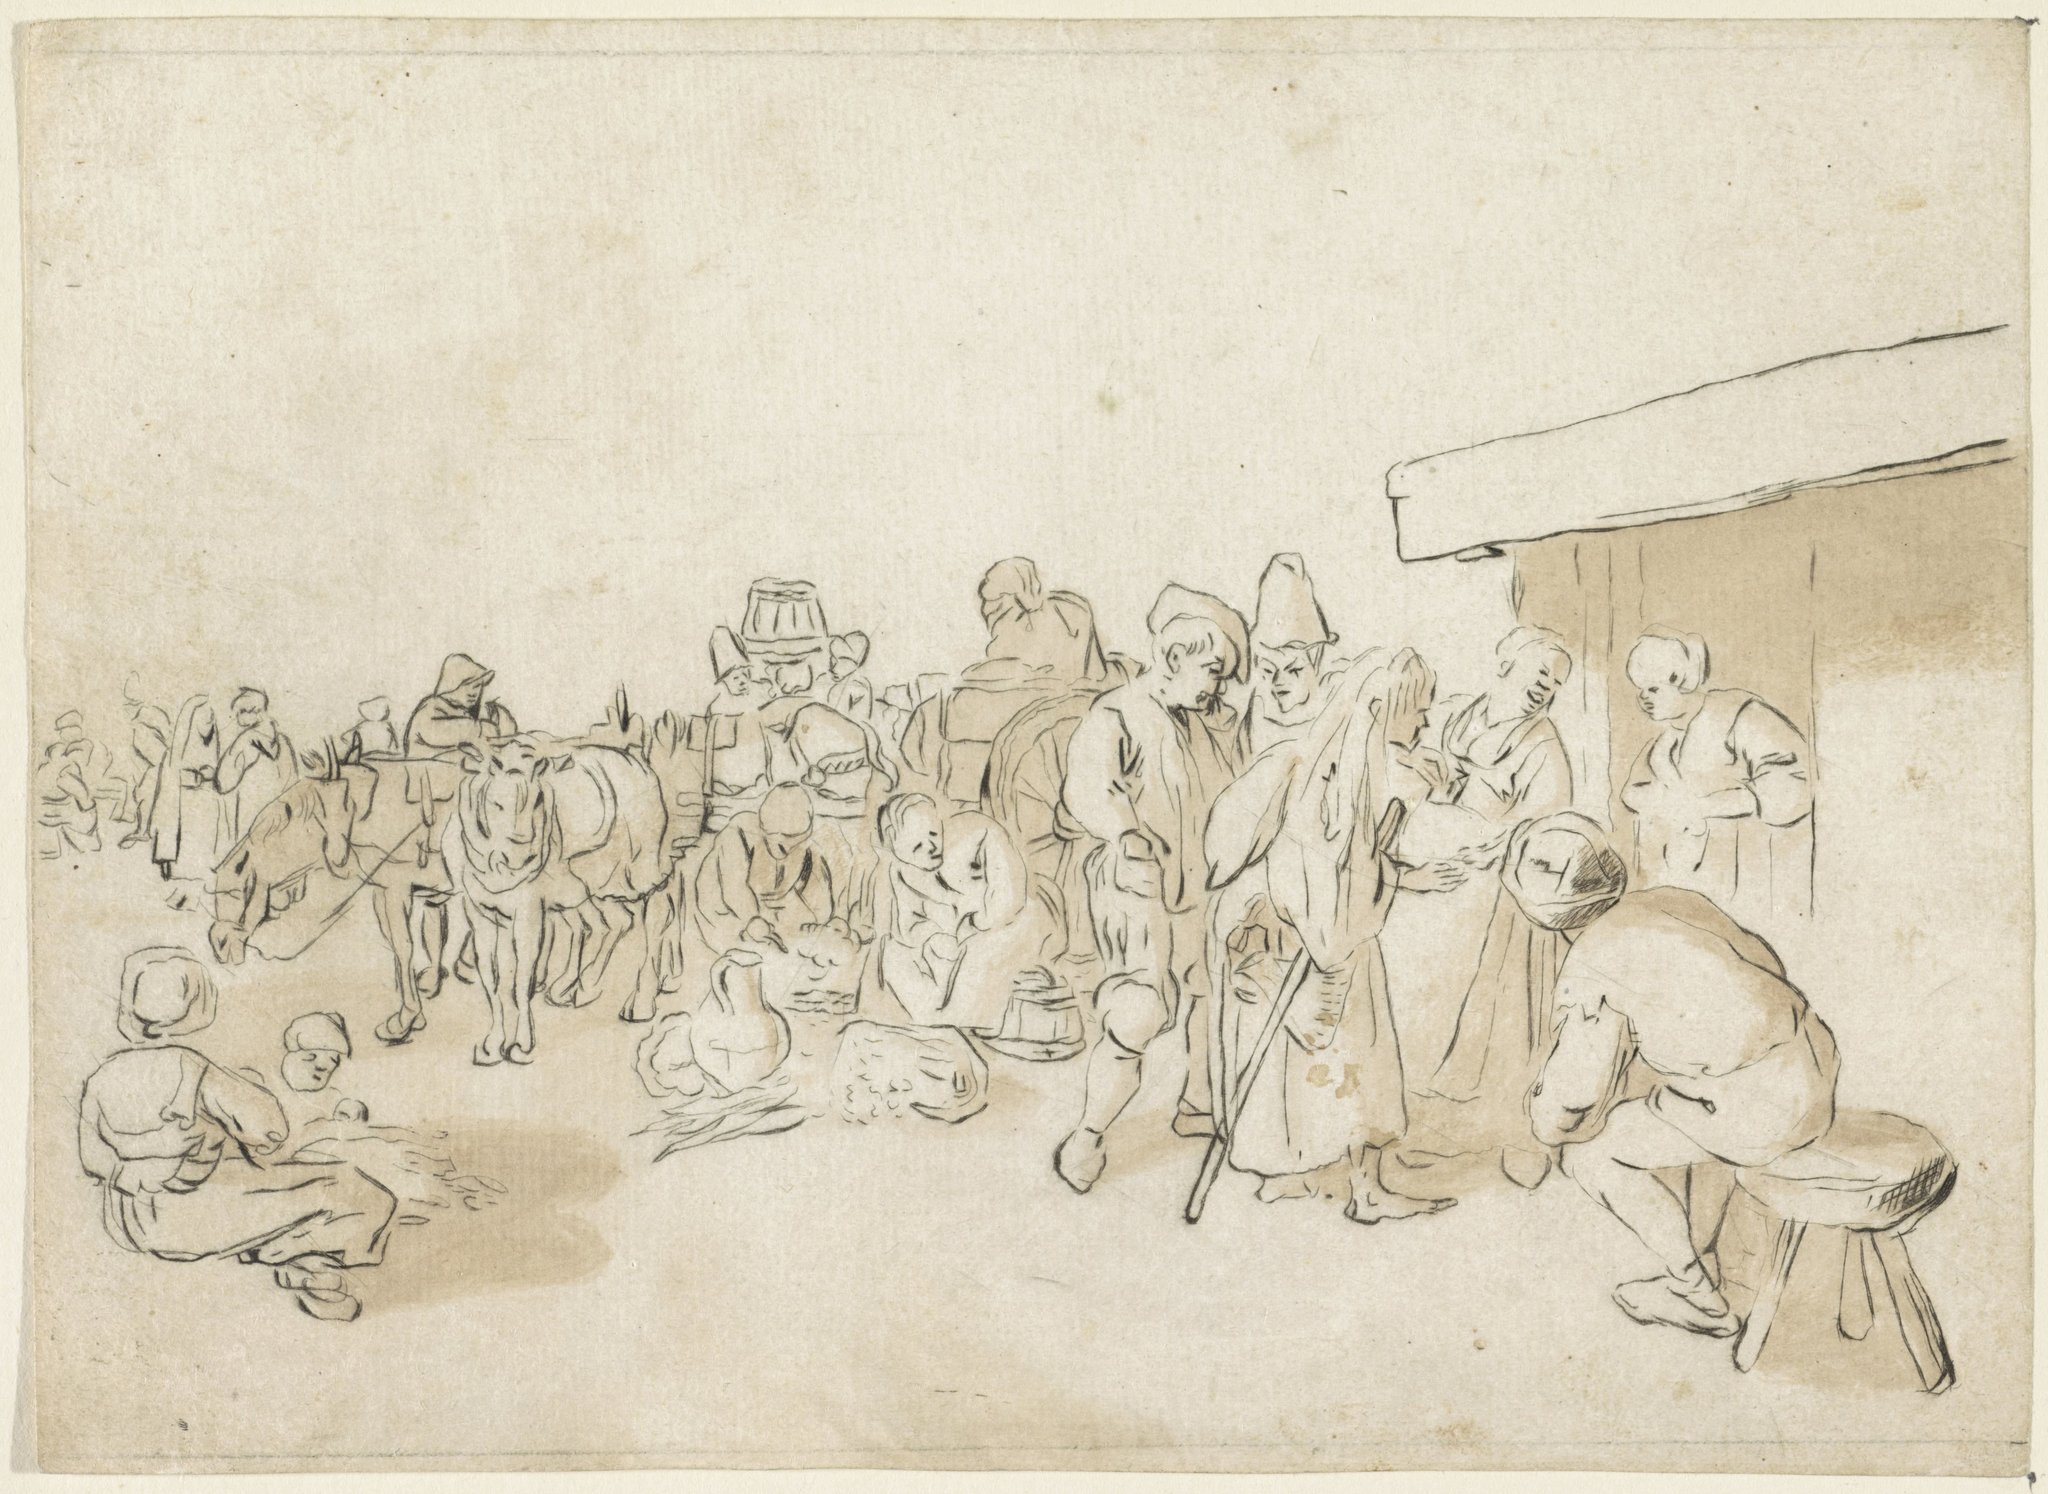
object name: print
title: Markt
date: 1735-1787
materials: paper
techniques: etching, hand coloring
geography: amsterdam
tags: horse, market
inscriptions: collector's mark: Lugt 2760, collector's mark: Lugt 2228, inscription: ‘J. Dassonville delin. W: van Wessem fecit’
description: Een mensenmenigte op een markt. Rechts een vrouw leunend op een onderdeur.